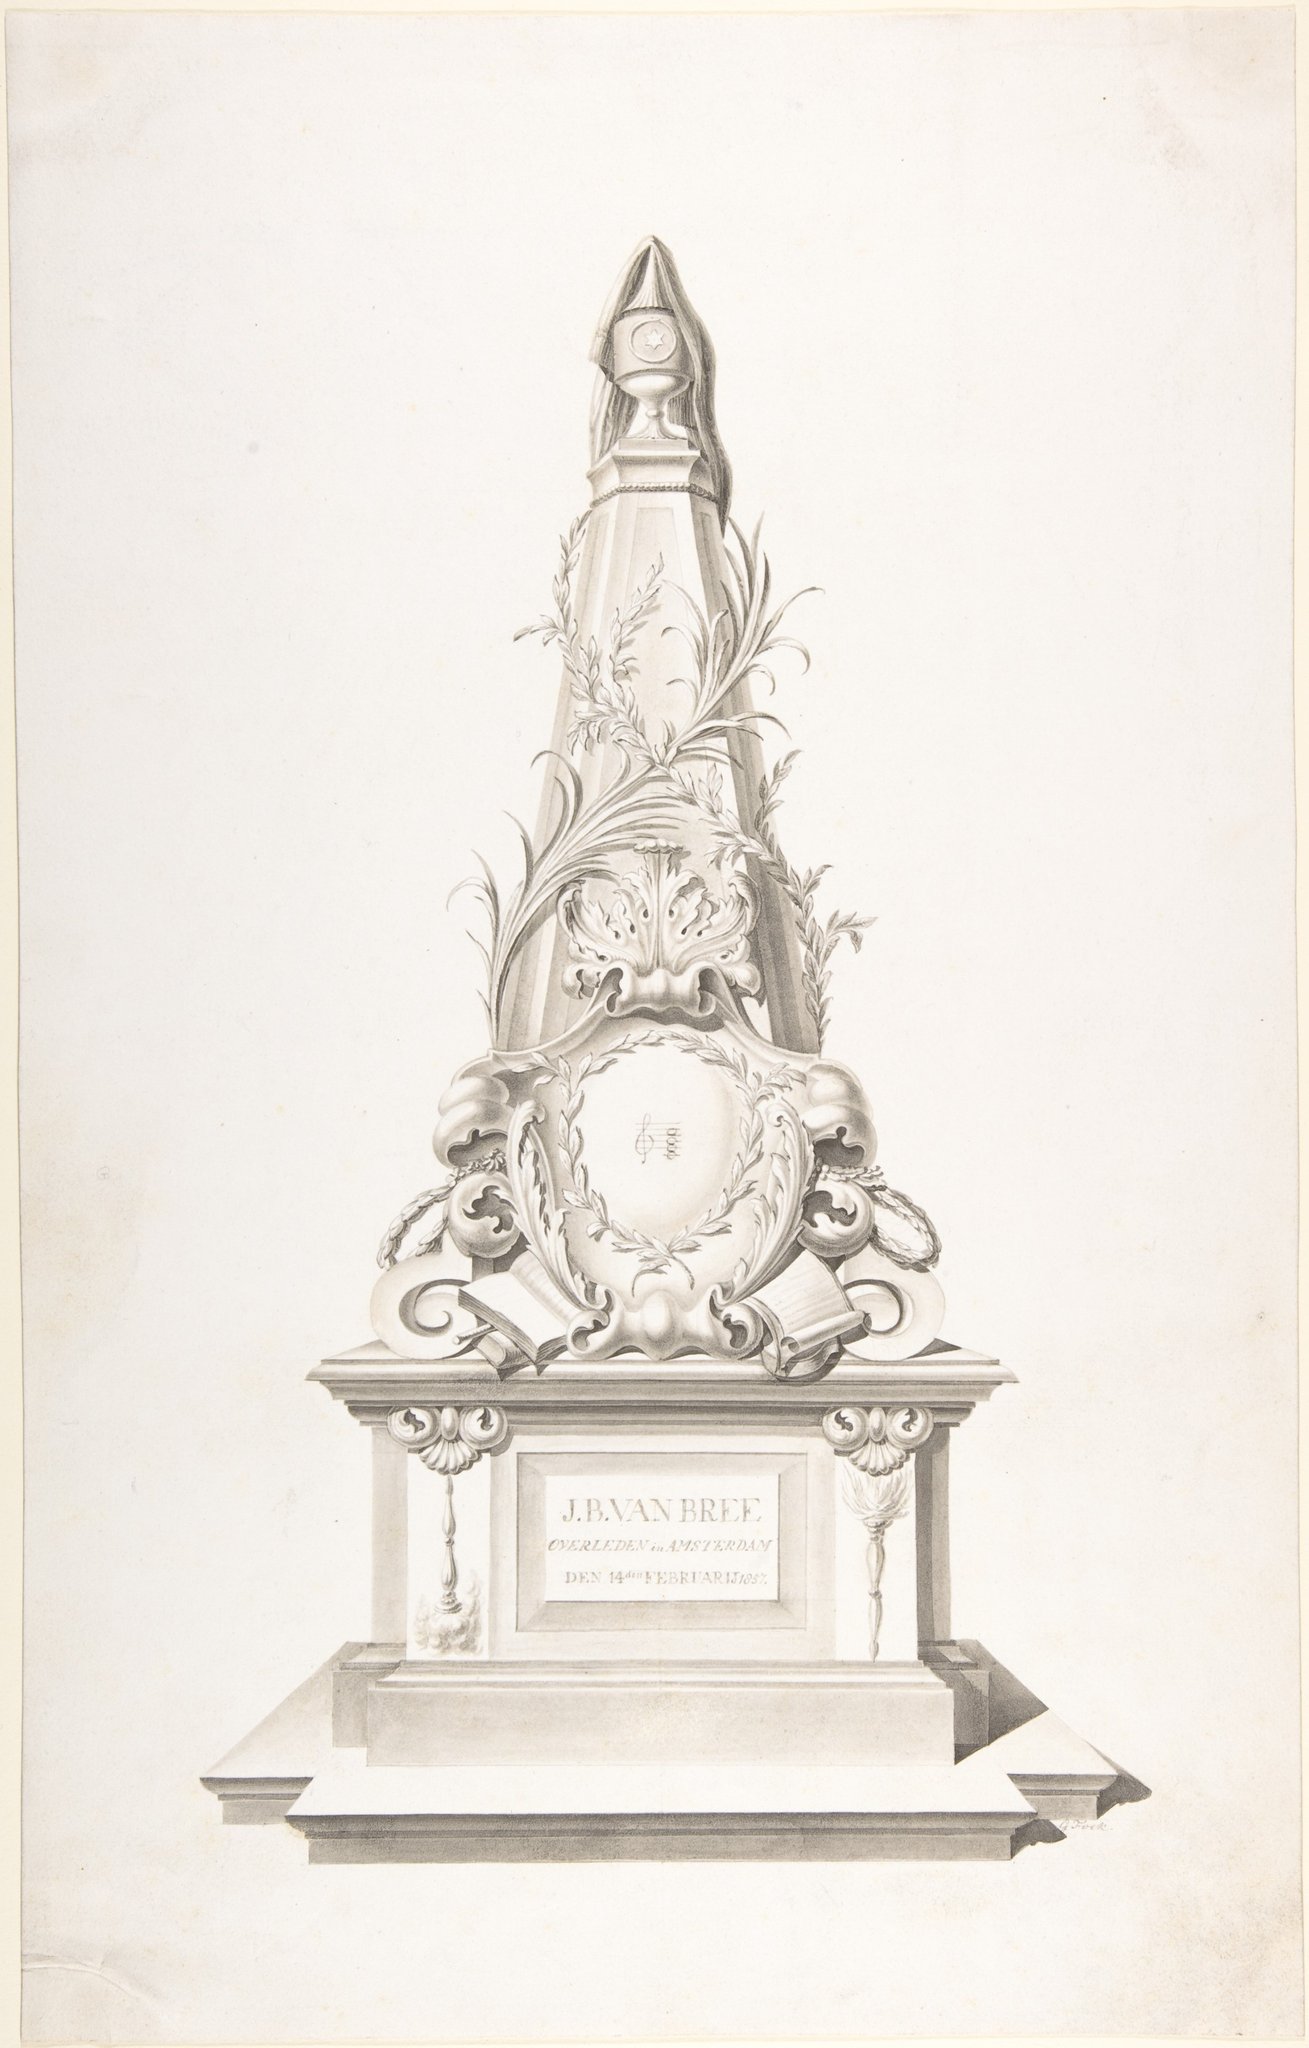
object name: drawing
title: Pyramid monument for J.B. van Bree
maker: g. fock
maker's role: artist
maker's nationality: dutch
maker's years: 1857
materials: graphite, ink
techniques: brush, pen, wash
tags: monuments,leaves